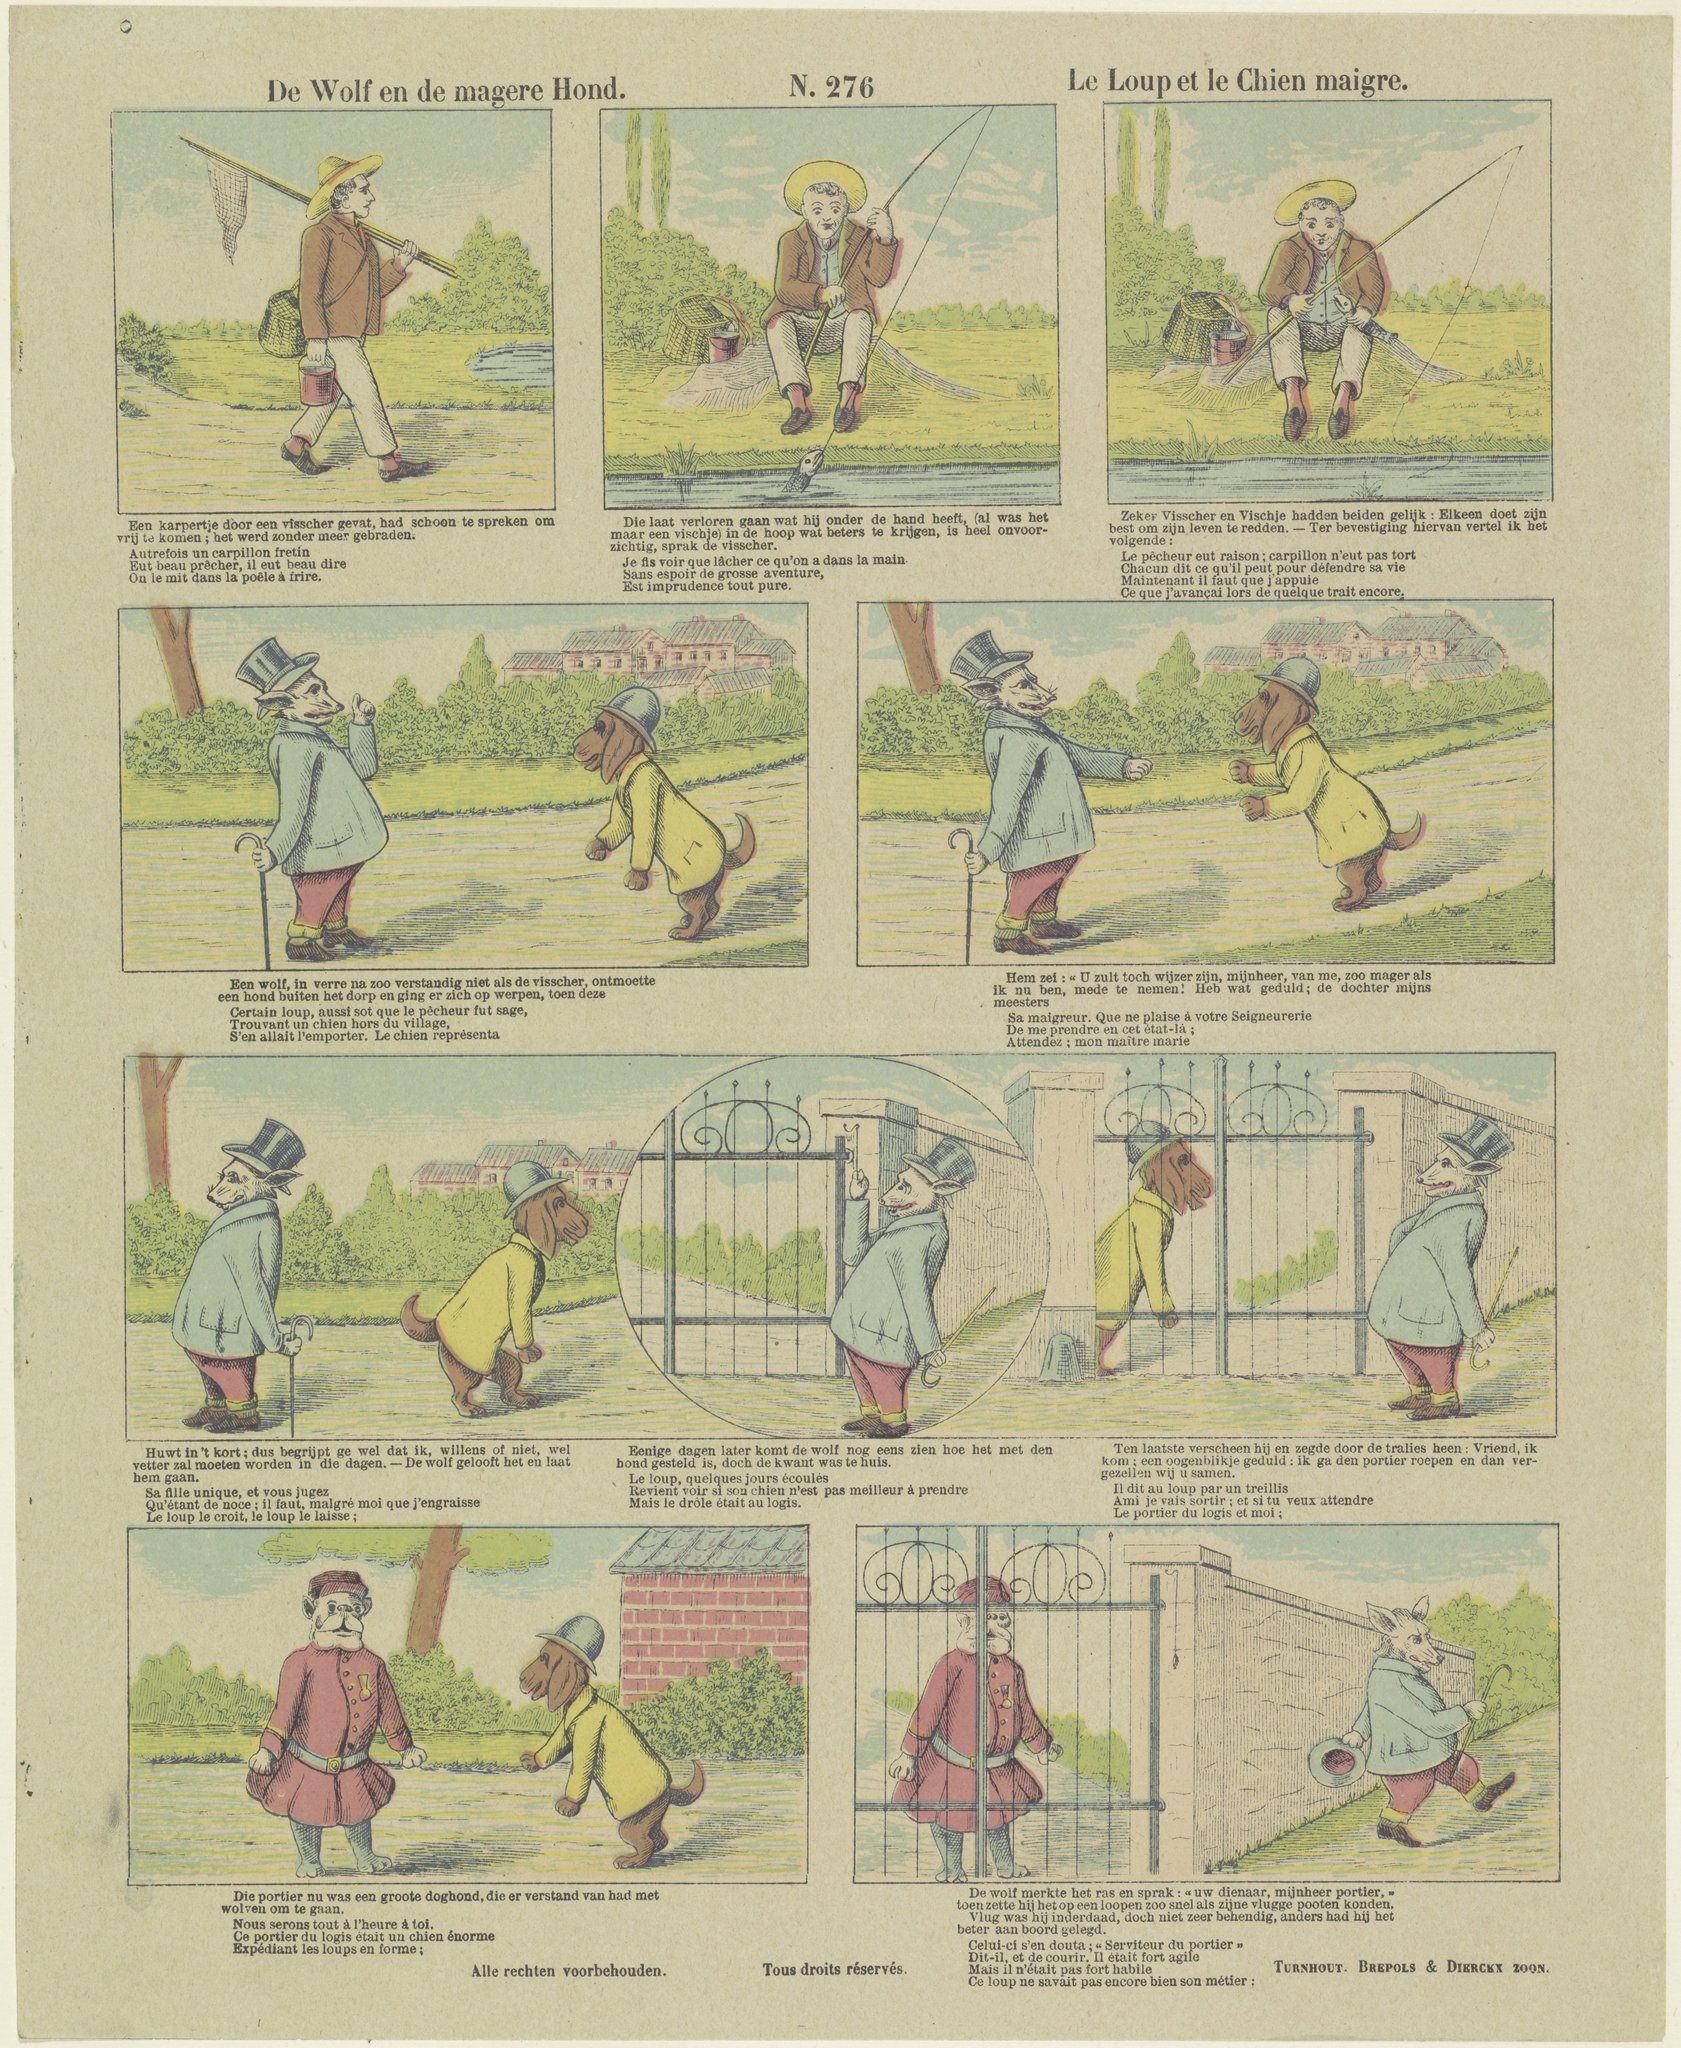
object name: print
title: De wolf en de magere hond / Le loup et le chien maigre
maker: Anonymous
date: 1833-1911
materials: paper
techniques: lithograph, letterpress printing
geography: turnhout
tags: animals acting as human beings, tales and fairy tales, fisherman, dog, beasts of prey, predatory animals: wolf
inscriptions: collector's mark: Lugt 2760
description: Blad met 10 voorstellingen uit het verhaal van de wolf en de magere hond. Onder elke afbeelding een onderschrift in het Nederlands en in het Frans. Genummerd midden boven: N. 276.